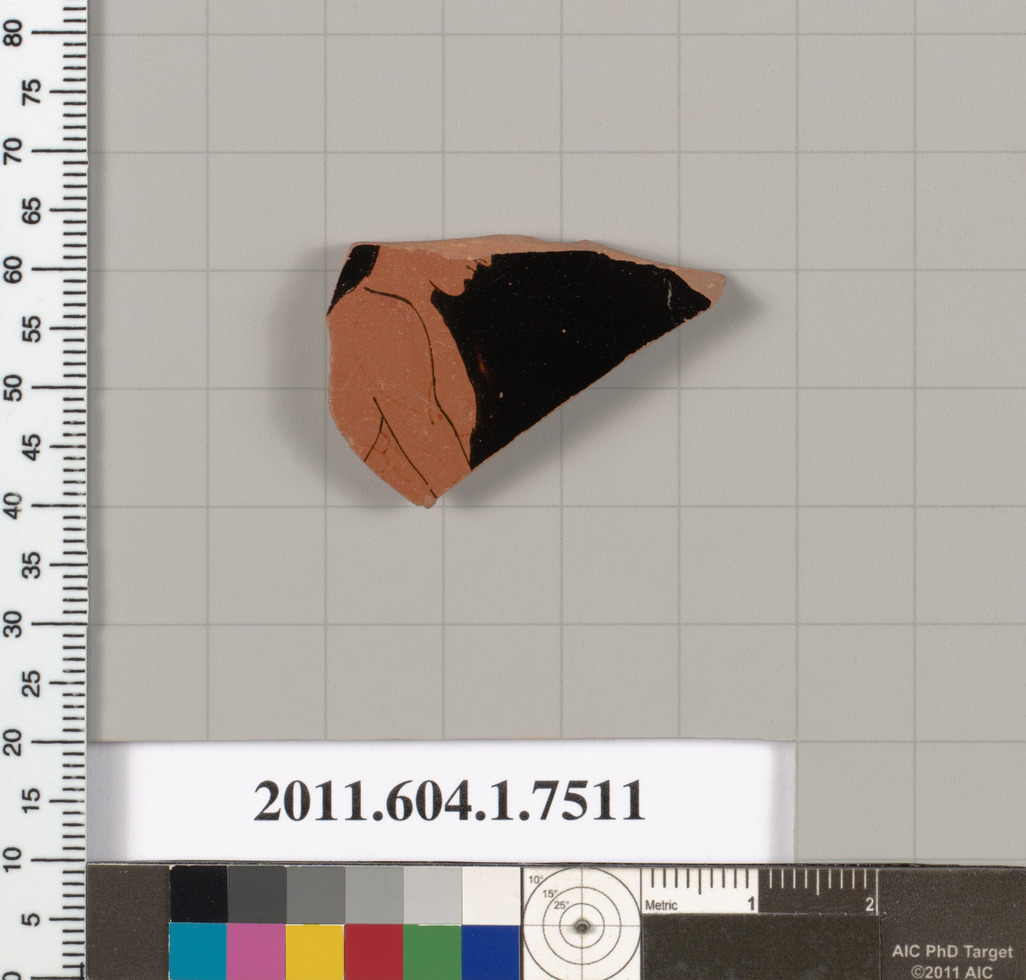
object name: kylix fragment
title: Terracotta fragment of a kylix (drinking cup)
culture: greek, attic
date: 460-450 BCE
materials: terracotta